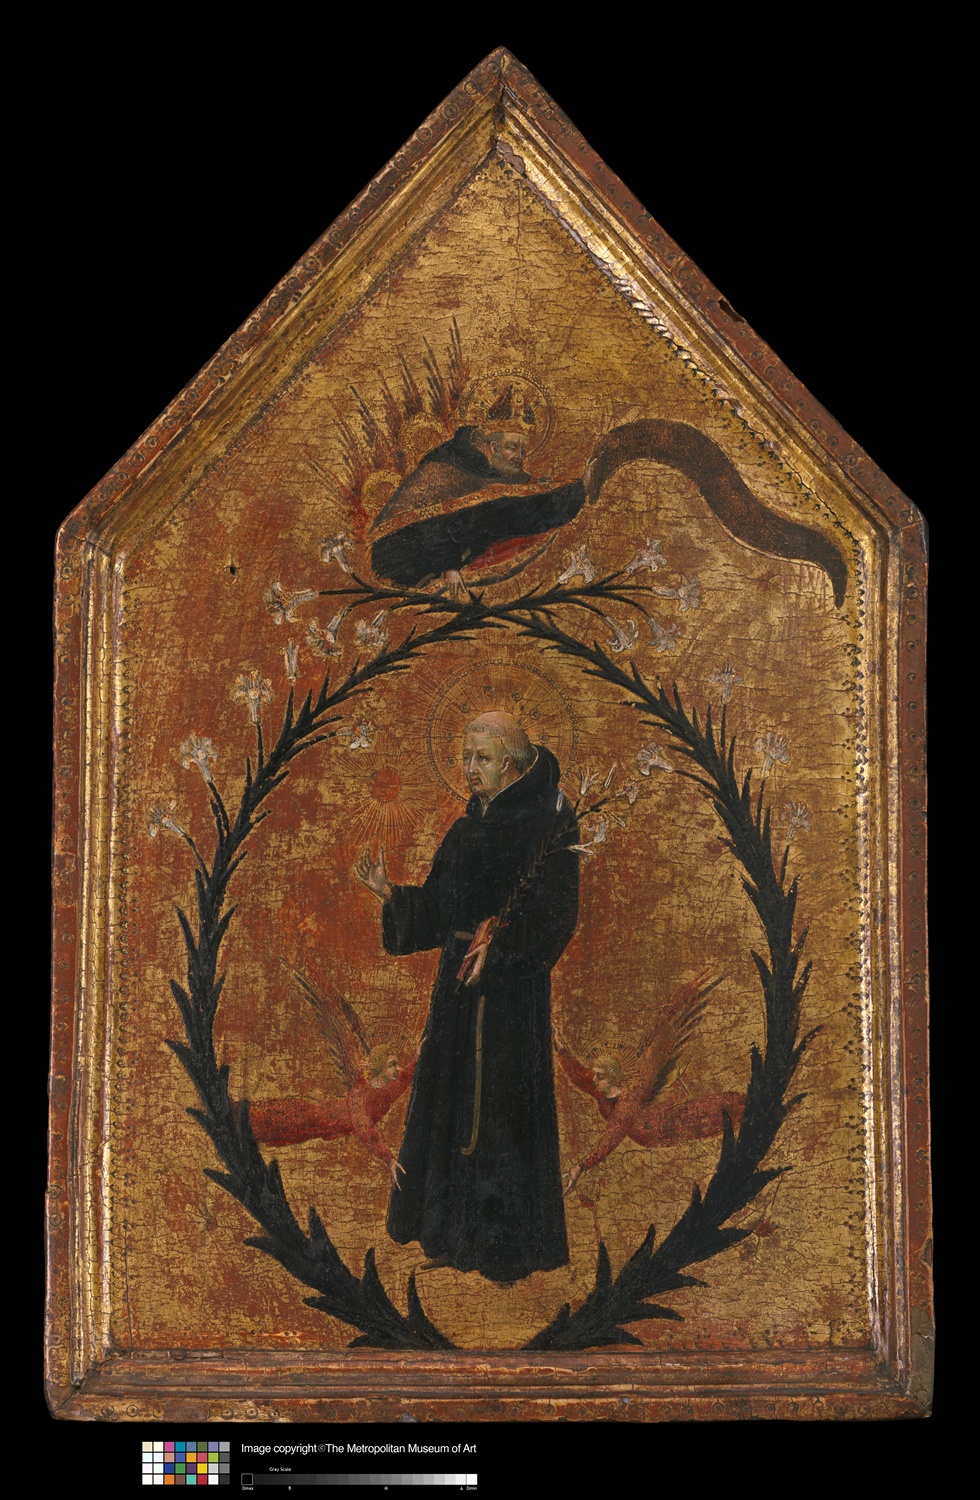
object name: frame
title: Engaged molding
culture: sienese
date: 1446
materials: gilt, wood